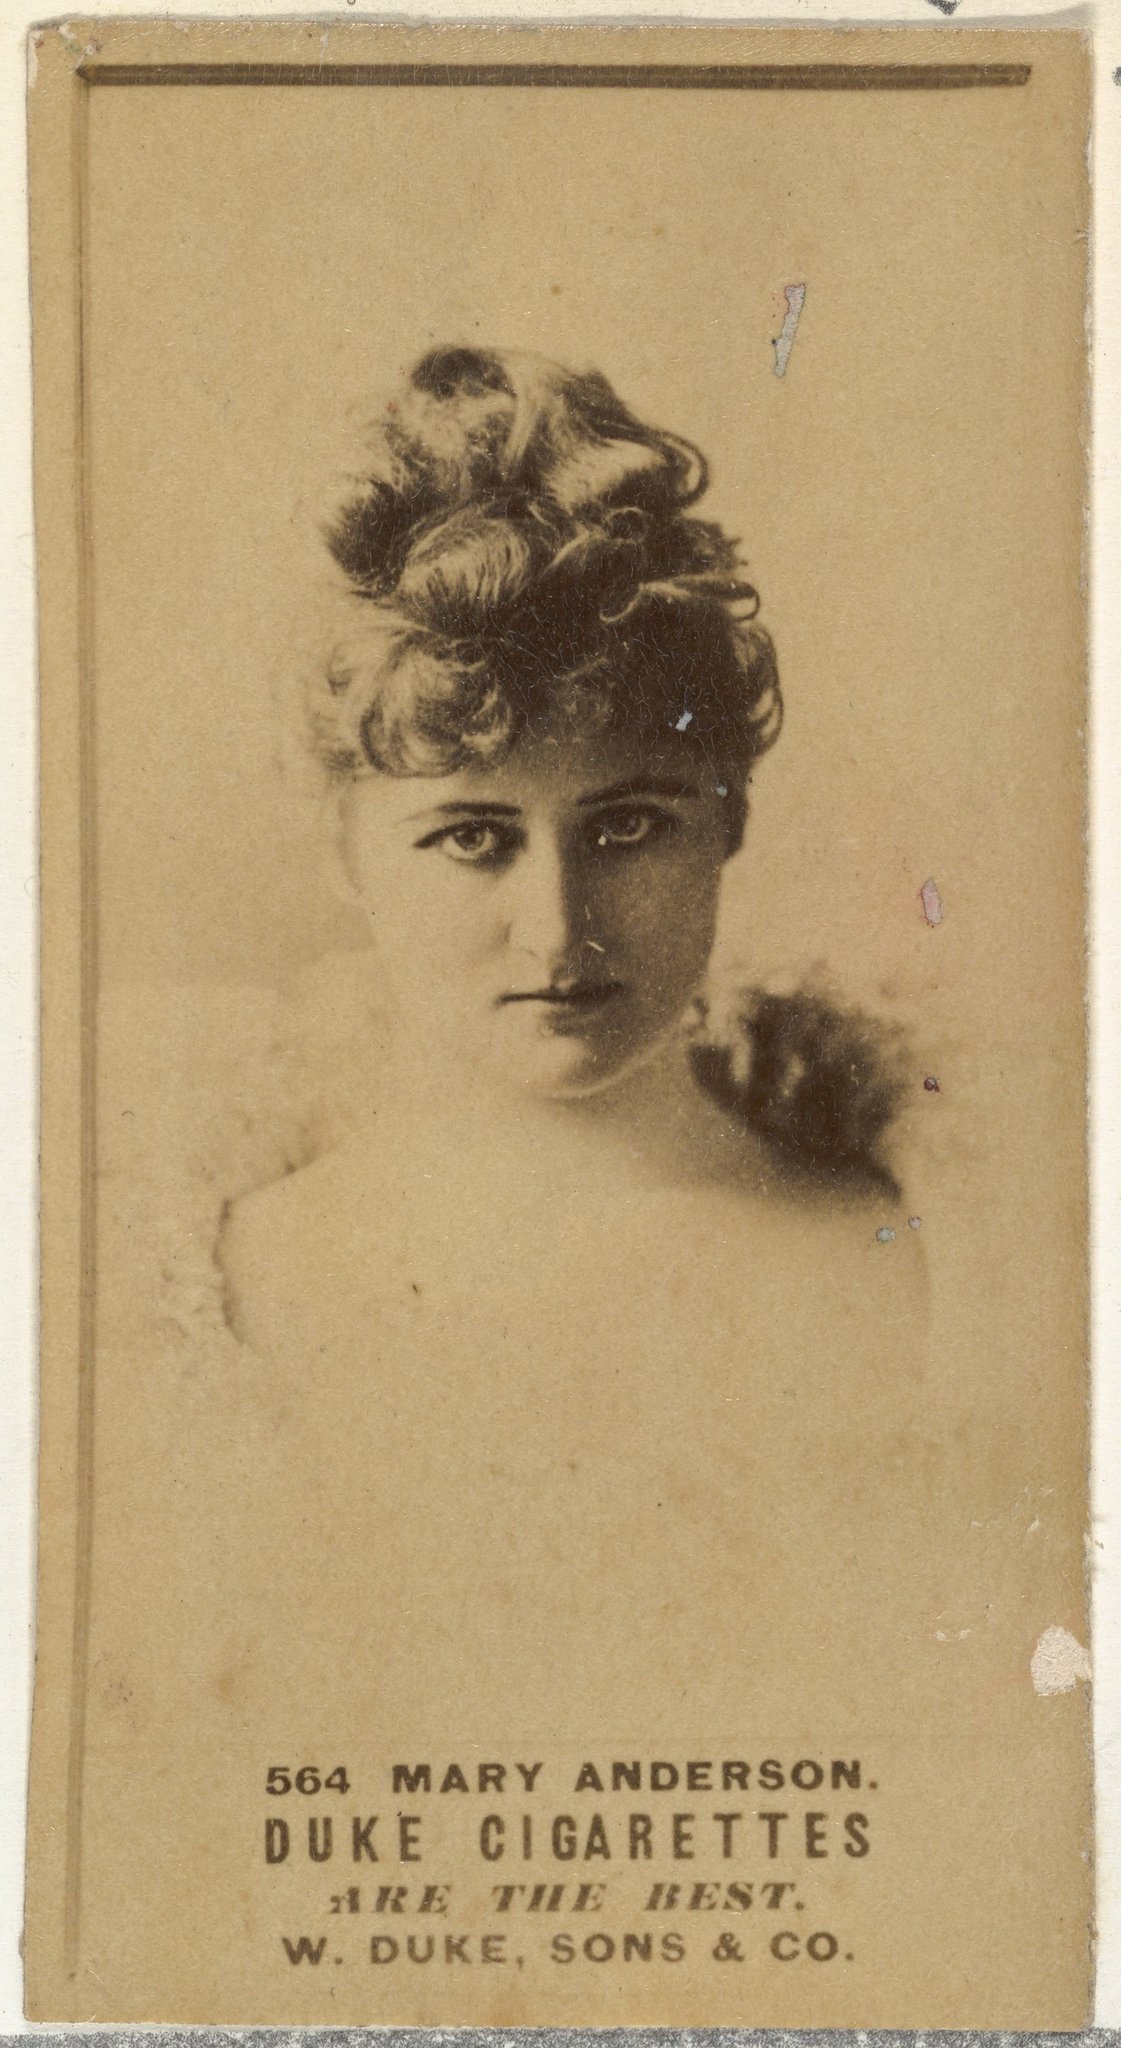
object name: photograph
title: Card Number 564, Mary Anderson, from the Actors and Actresses series (N145-7) issued by Duke Sons & Co. to promote Duke Cigarettes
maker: w. duke, sons & co.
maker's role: publisher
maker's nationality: american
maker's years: 1870-1920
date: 1880-1889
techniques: albumen silver print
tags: portraits,women,actresses